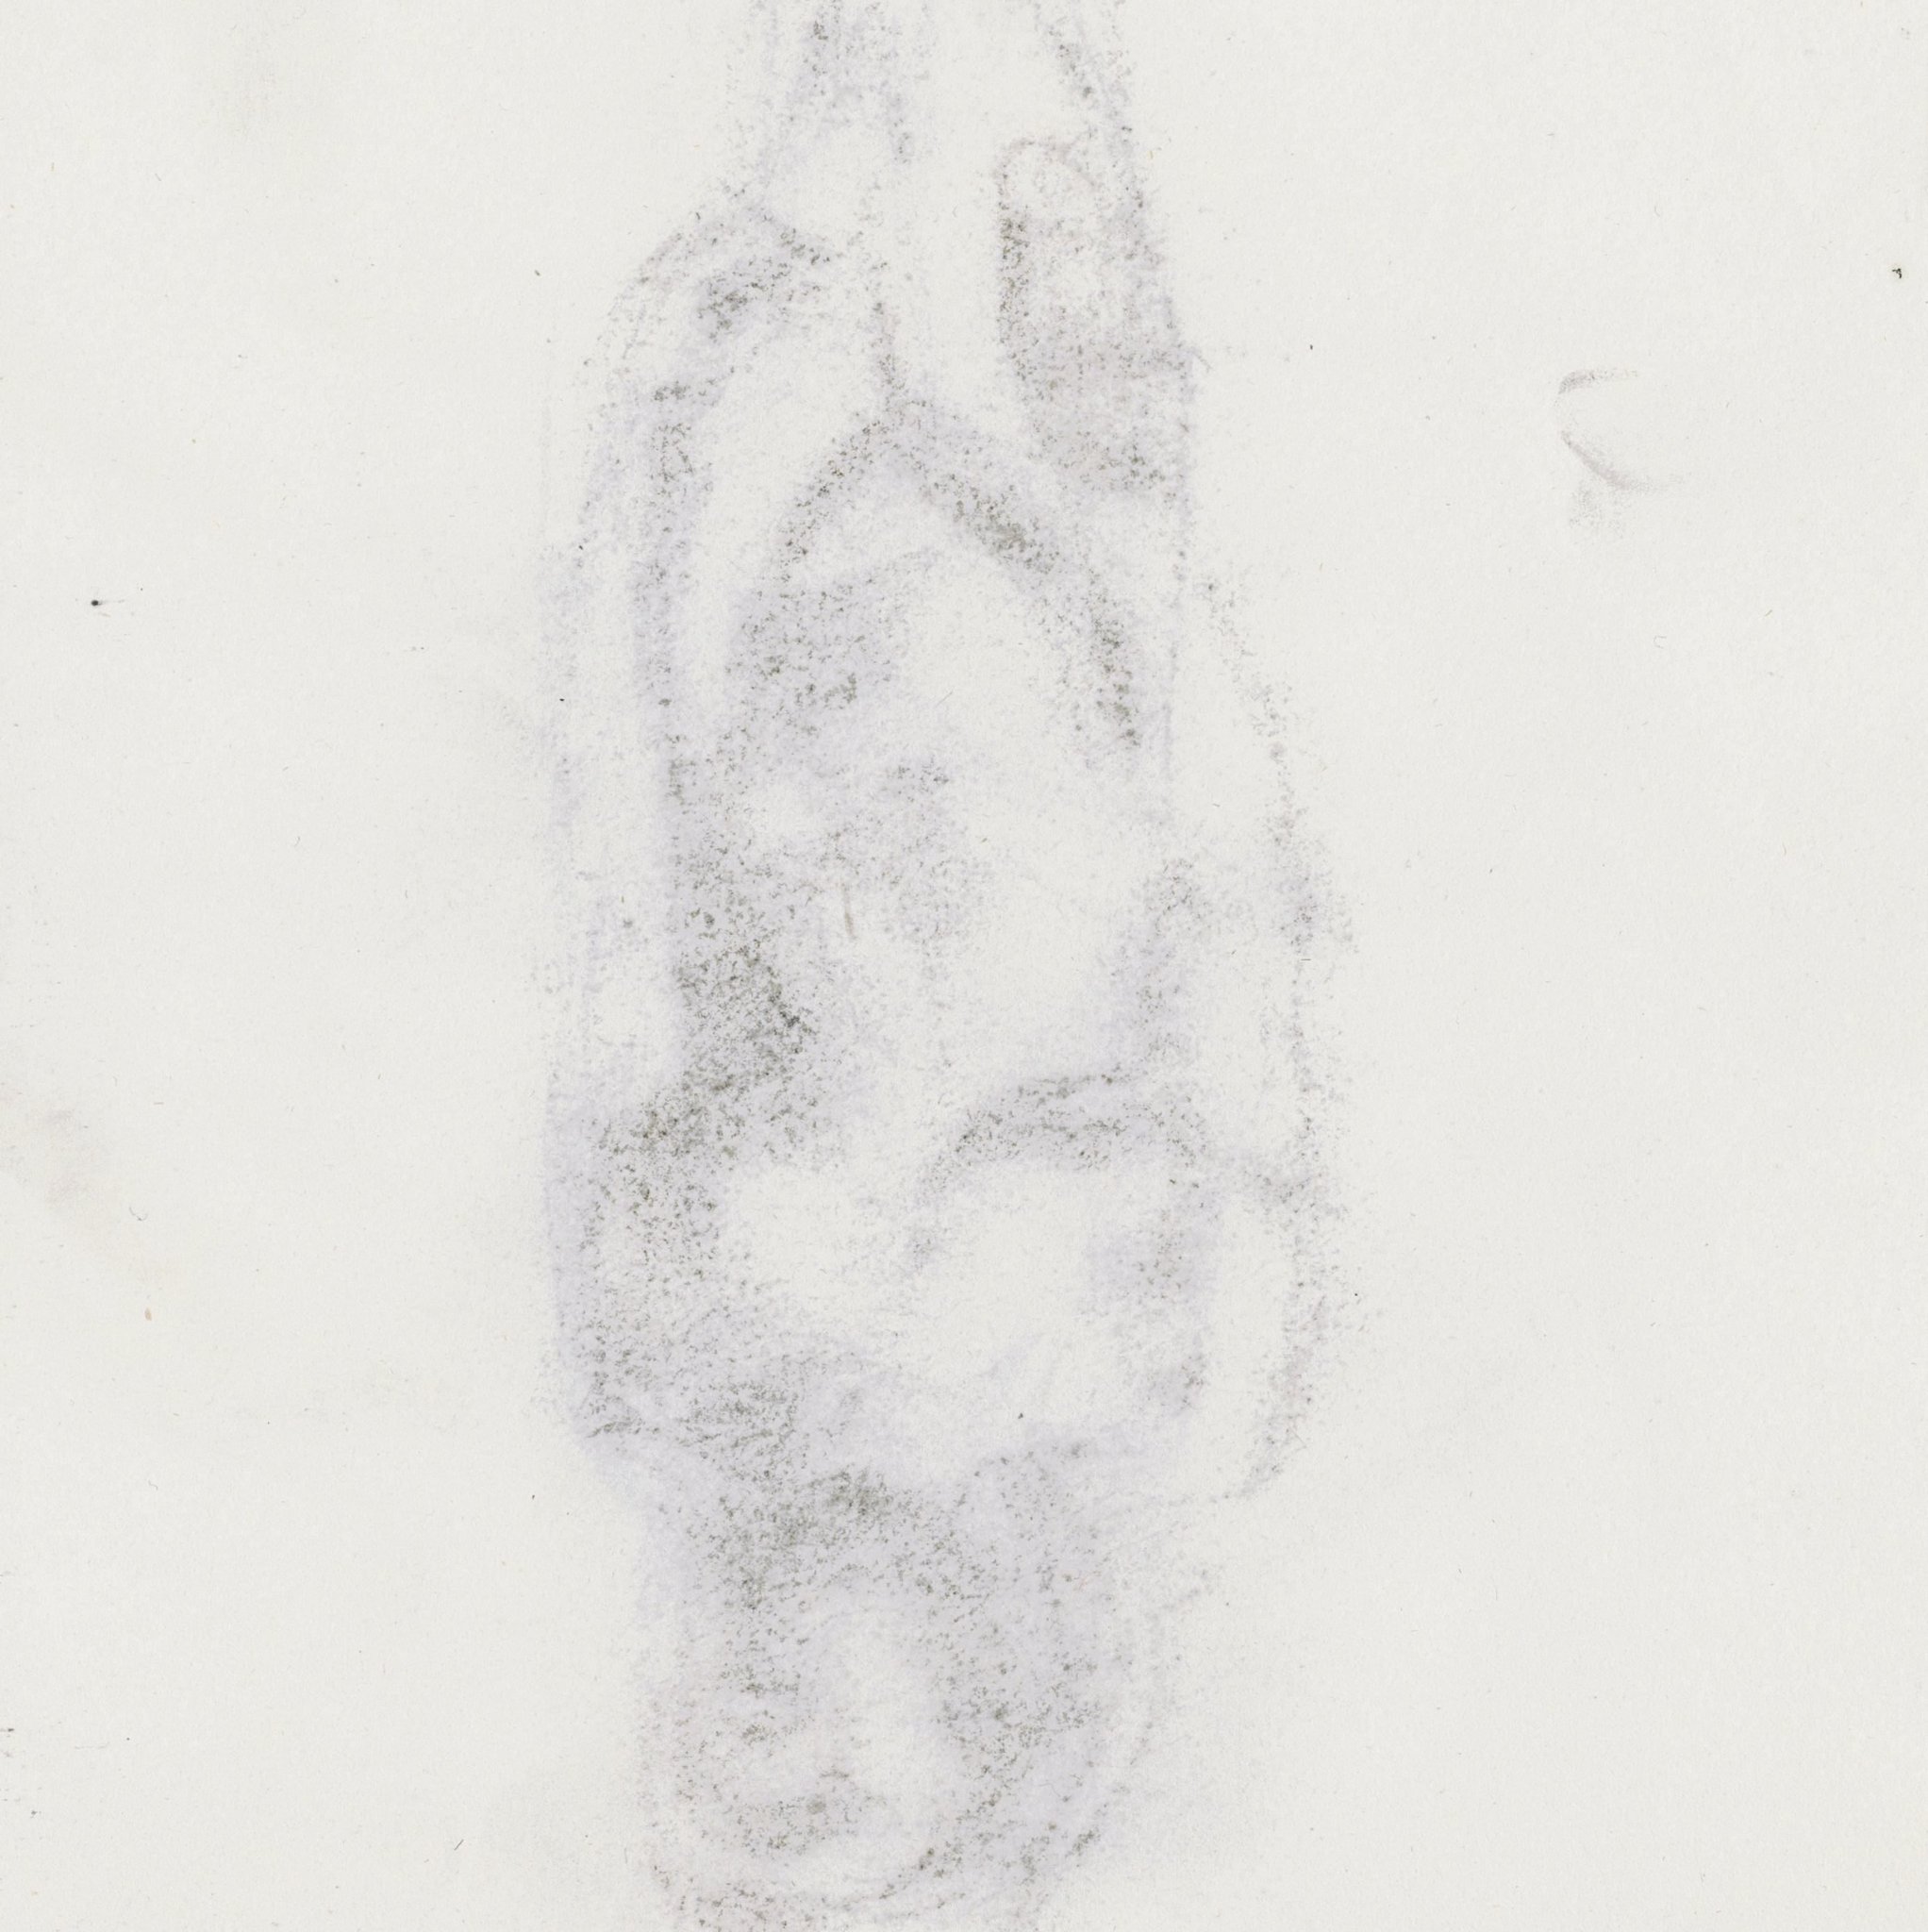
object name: sketchbook leaf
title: Abklatsch van de krijttekening op blad 18 verso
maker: isaac israels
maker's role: draughtsman, painter, print maker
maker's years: 1865-1934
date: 1875-1934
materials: paper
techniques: printmaking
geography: the hague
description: Blad 19 recto uit schetsboek IX met 28 bladen.